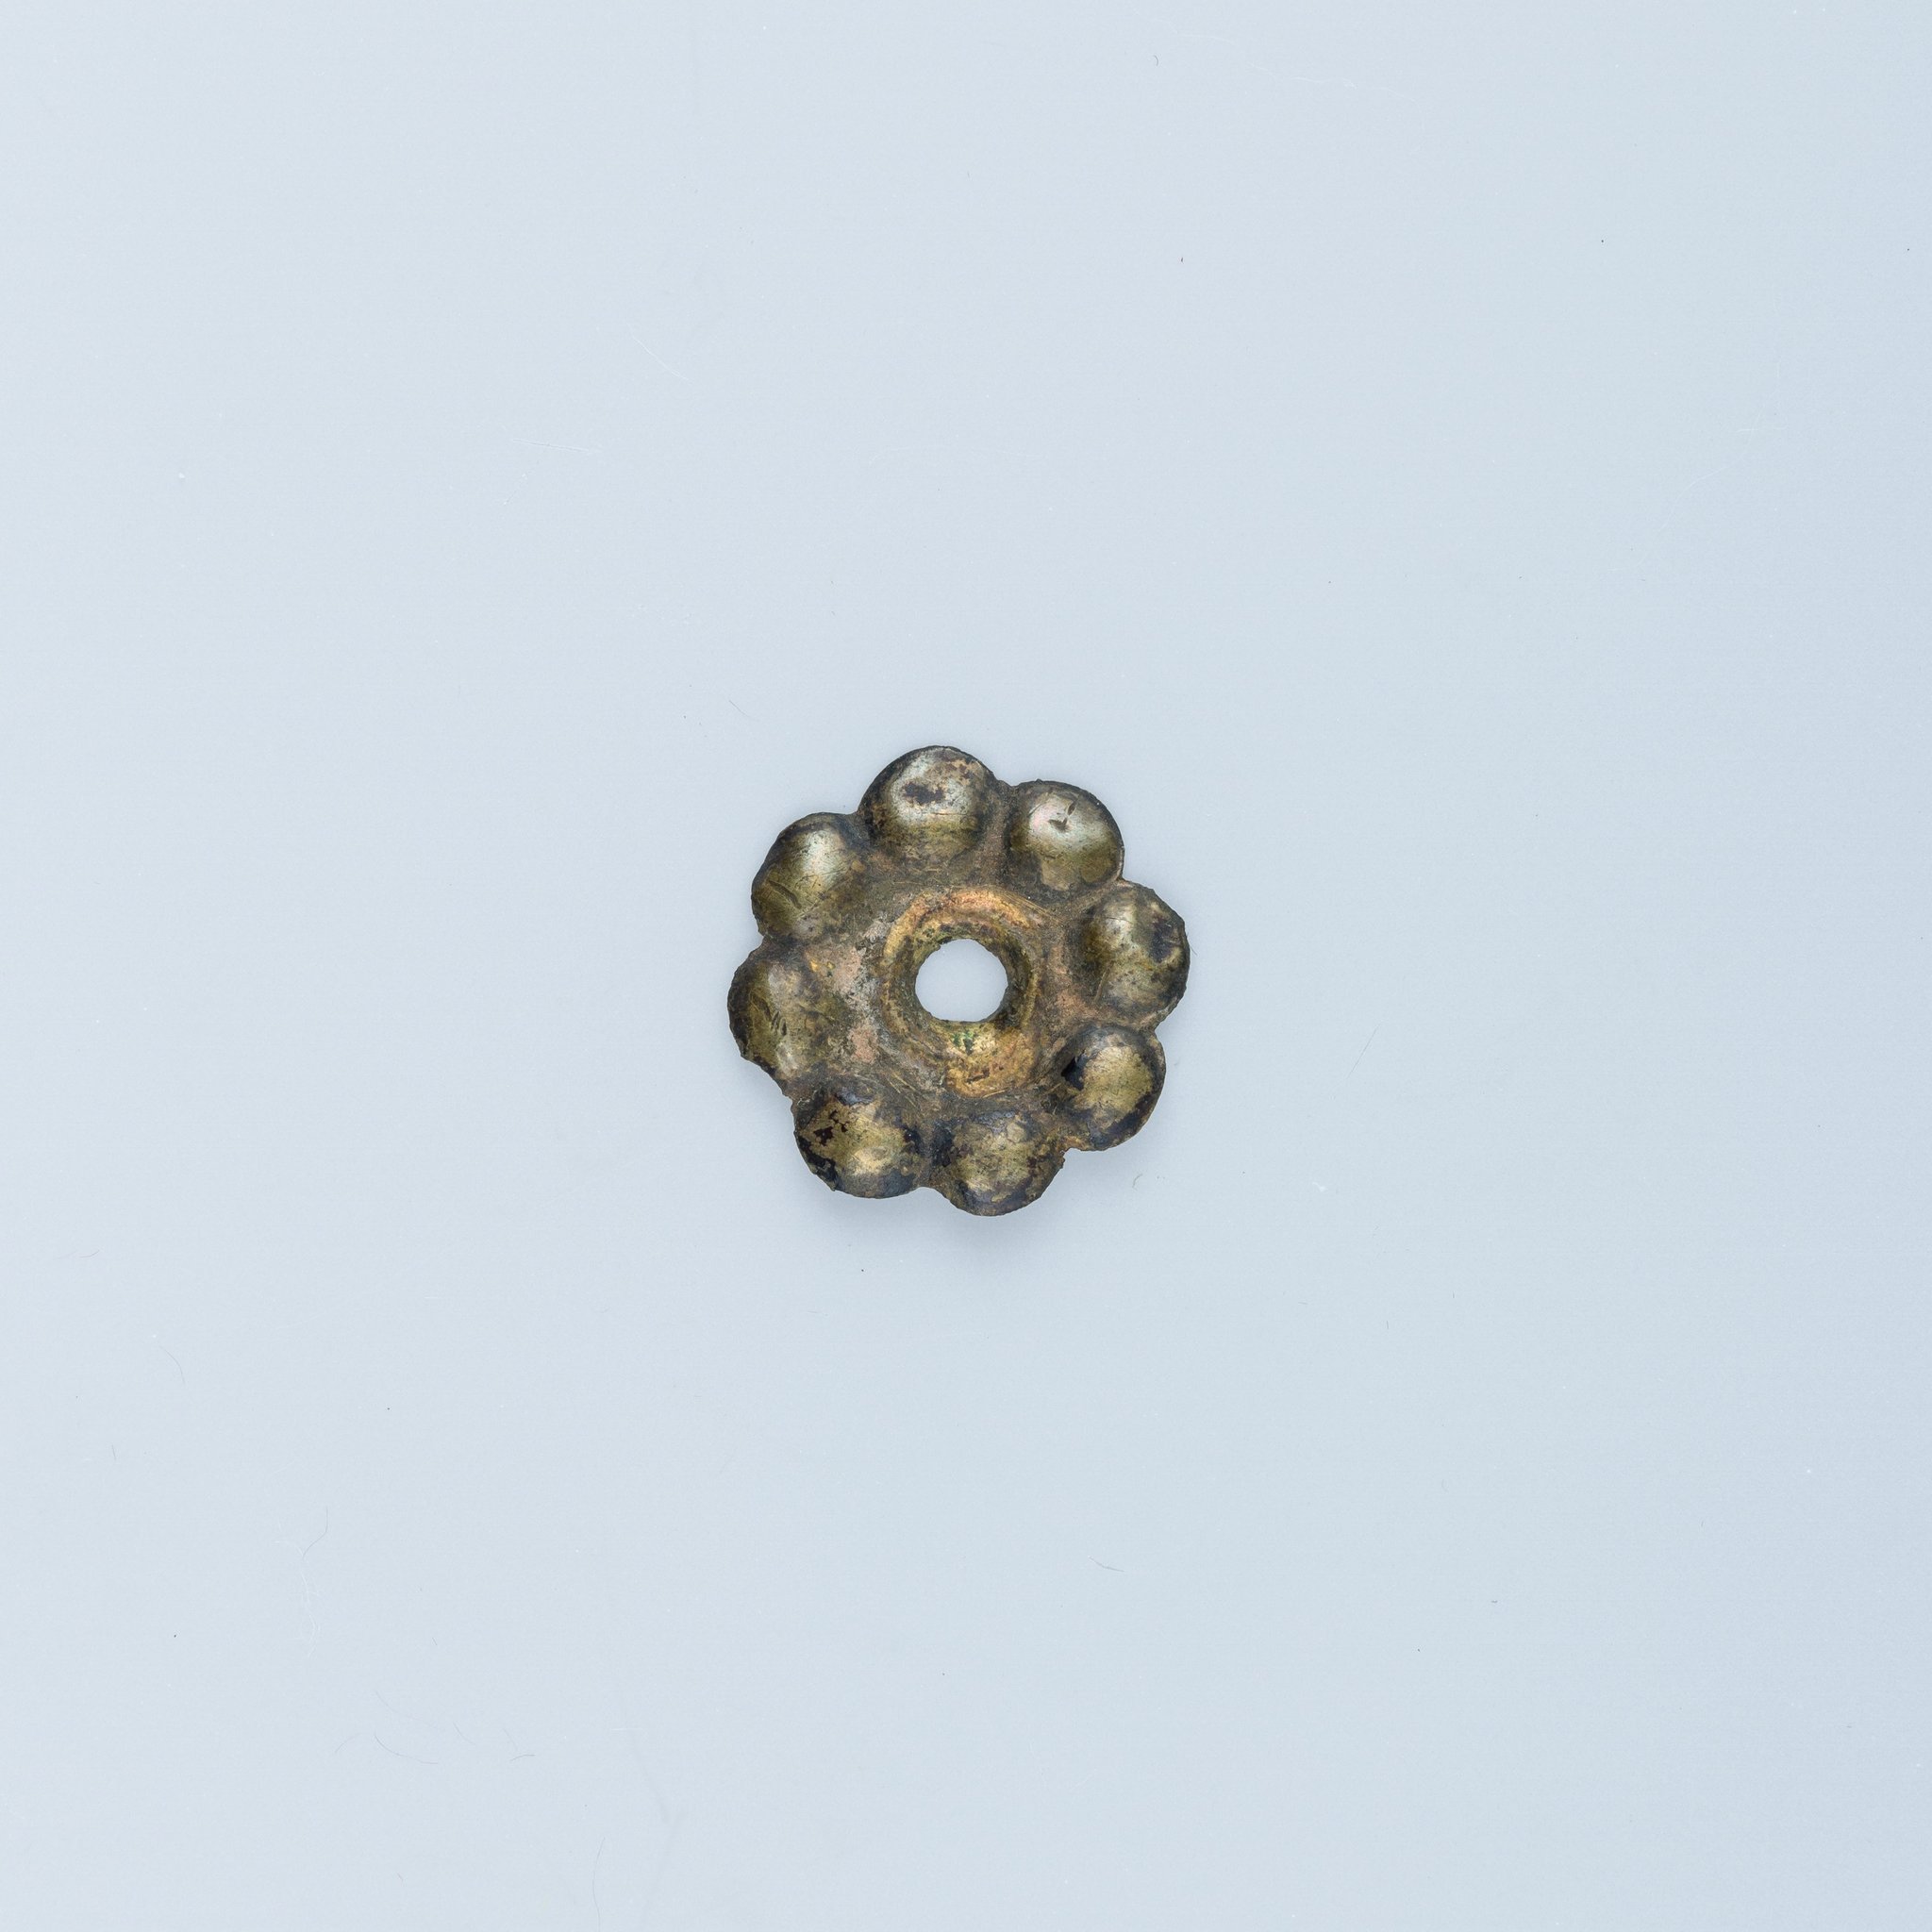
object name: rosette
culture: italian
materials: brass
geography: italy